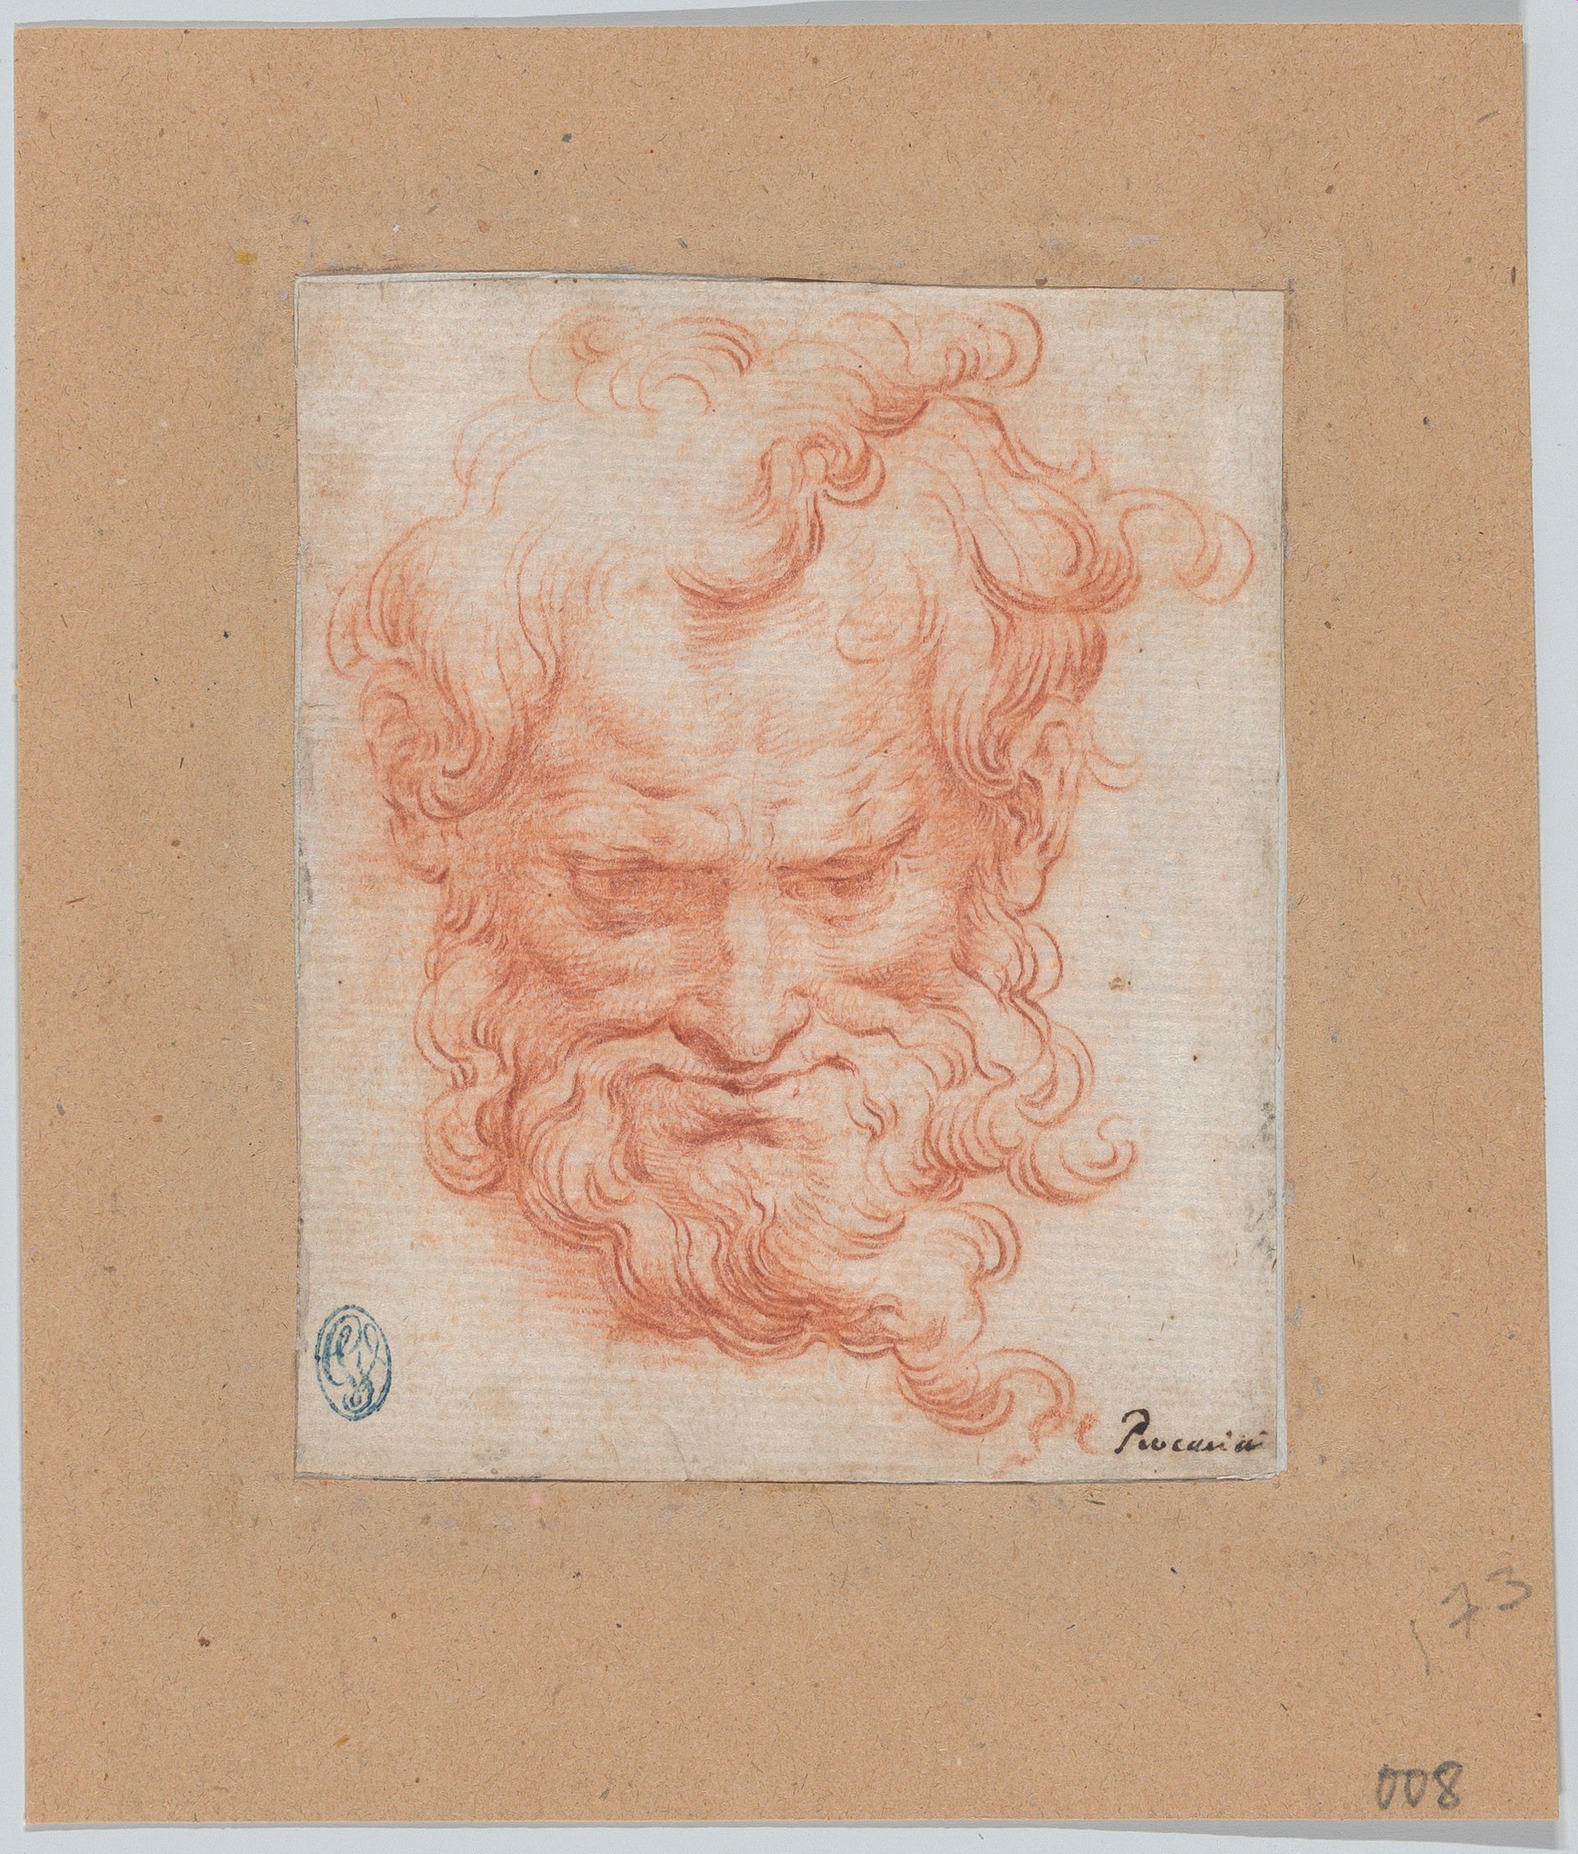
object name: drawing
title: Study of Bearded Man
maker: camillo procaccini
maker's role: artist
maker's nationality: italian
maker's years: 1555-1629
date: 1580-1600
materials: chalk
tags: heads,men